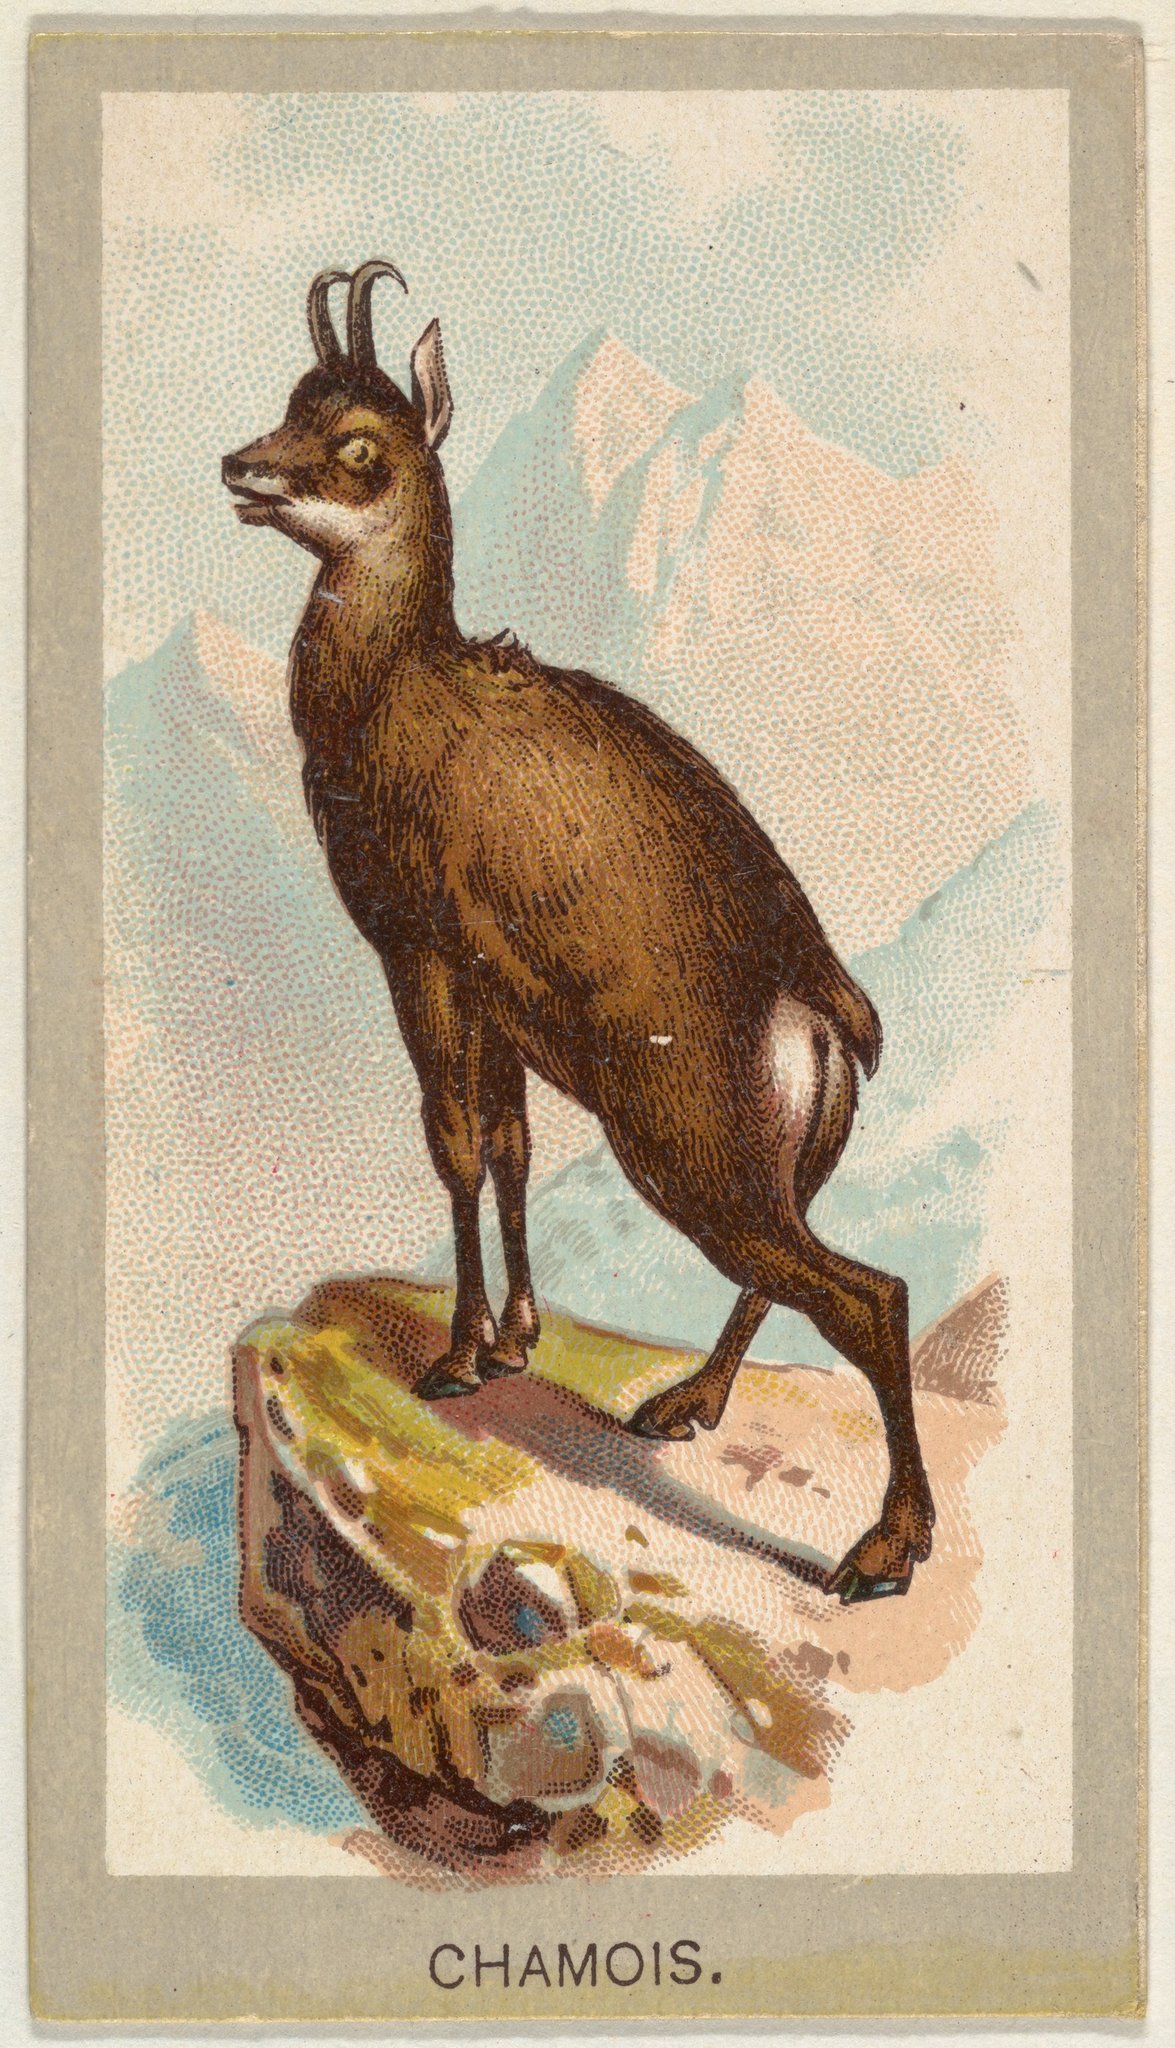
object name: print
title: Chamois, from the Animals of the World series (T180), issued by Abdul Cigarettes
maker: abdul cigarettes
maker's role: publisher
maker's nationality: american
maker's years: 1881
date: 1881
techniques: color lithograph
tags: animals